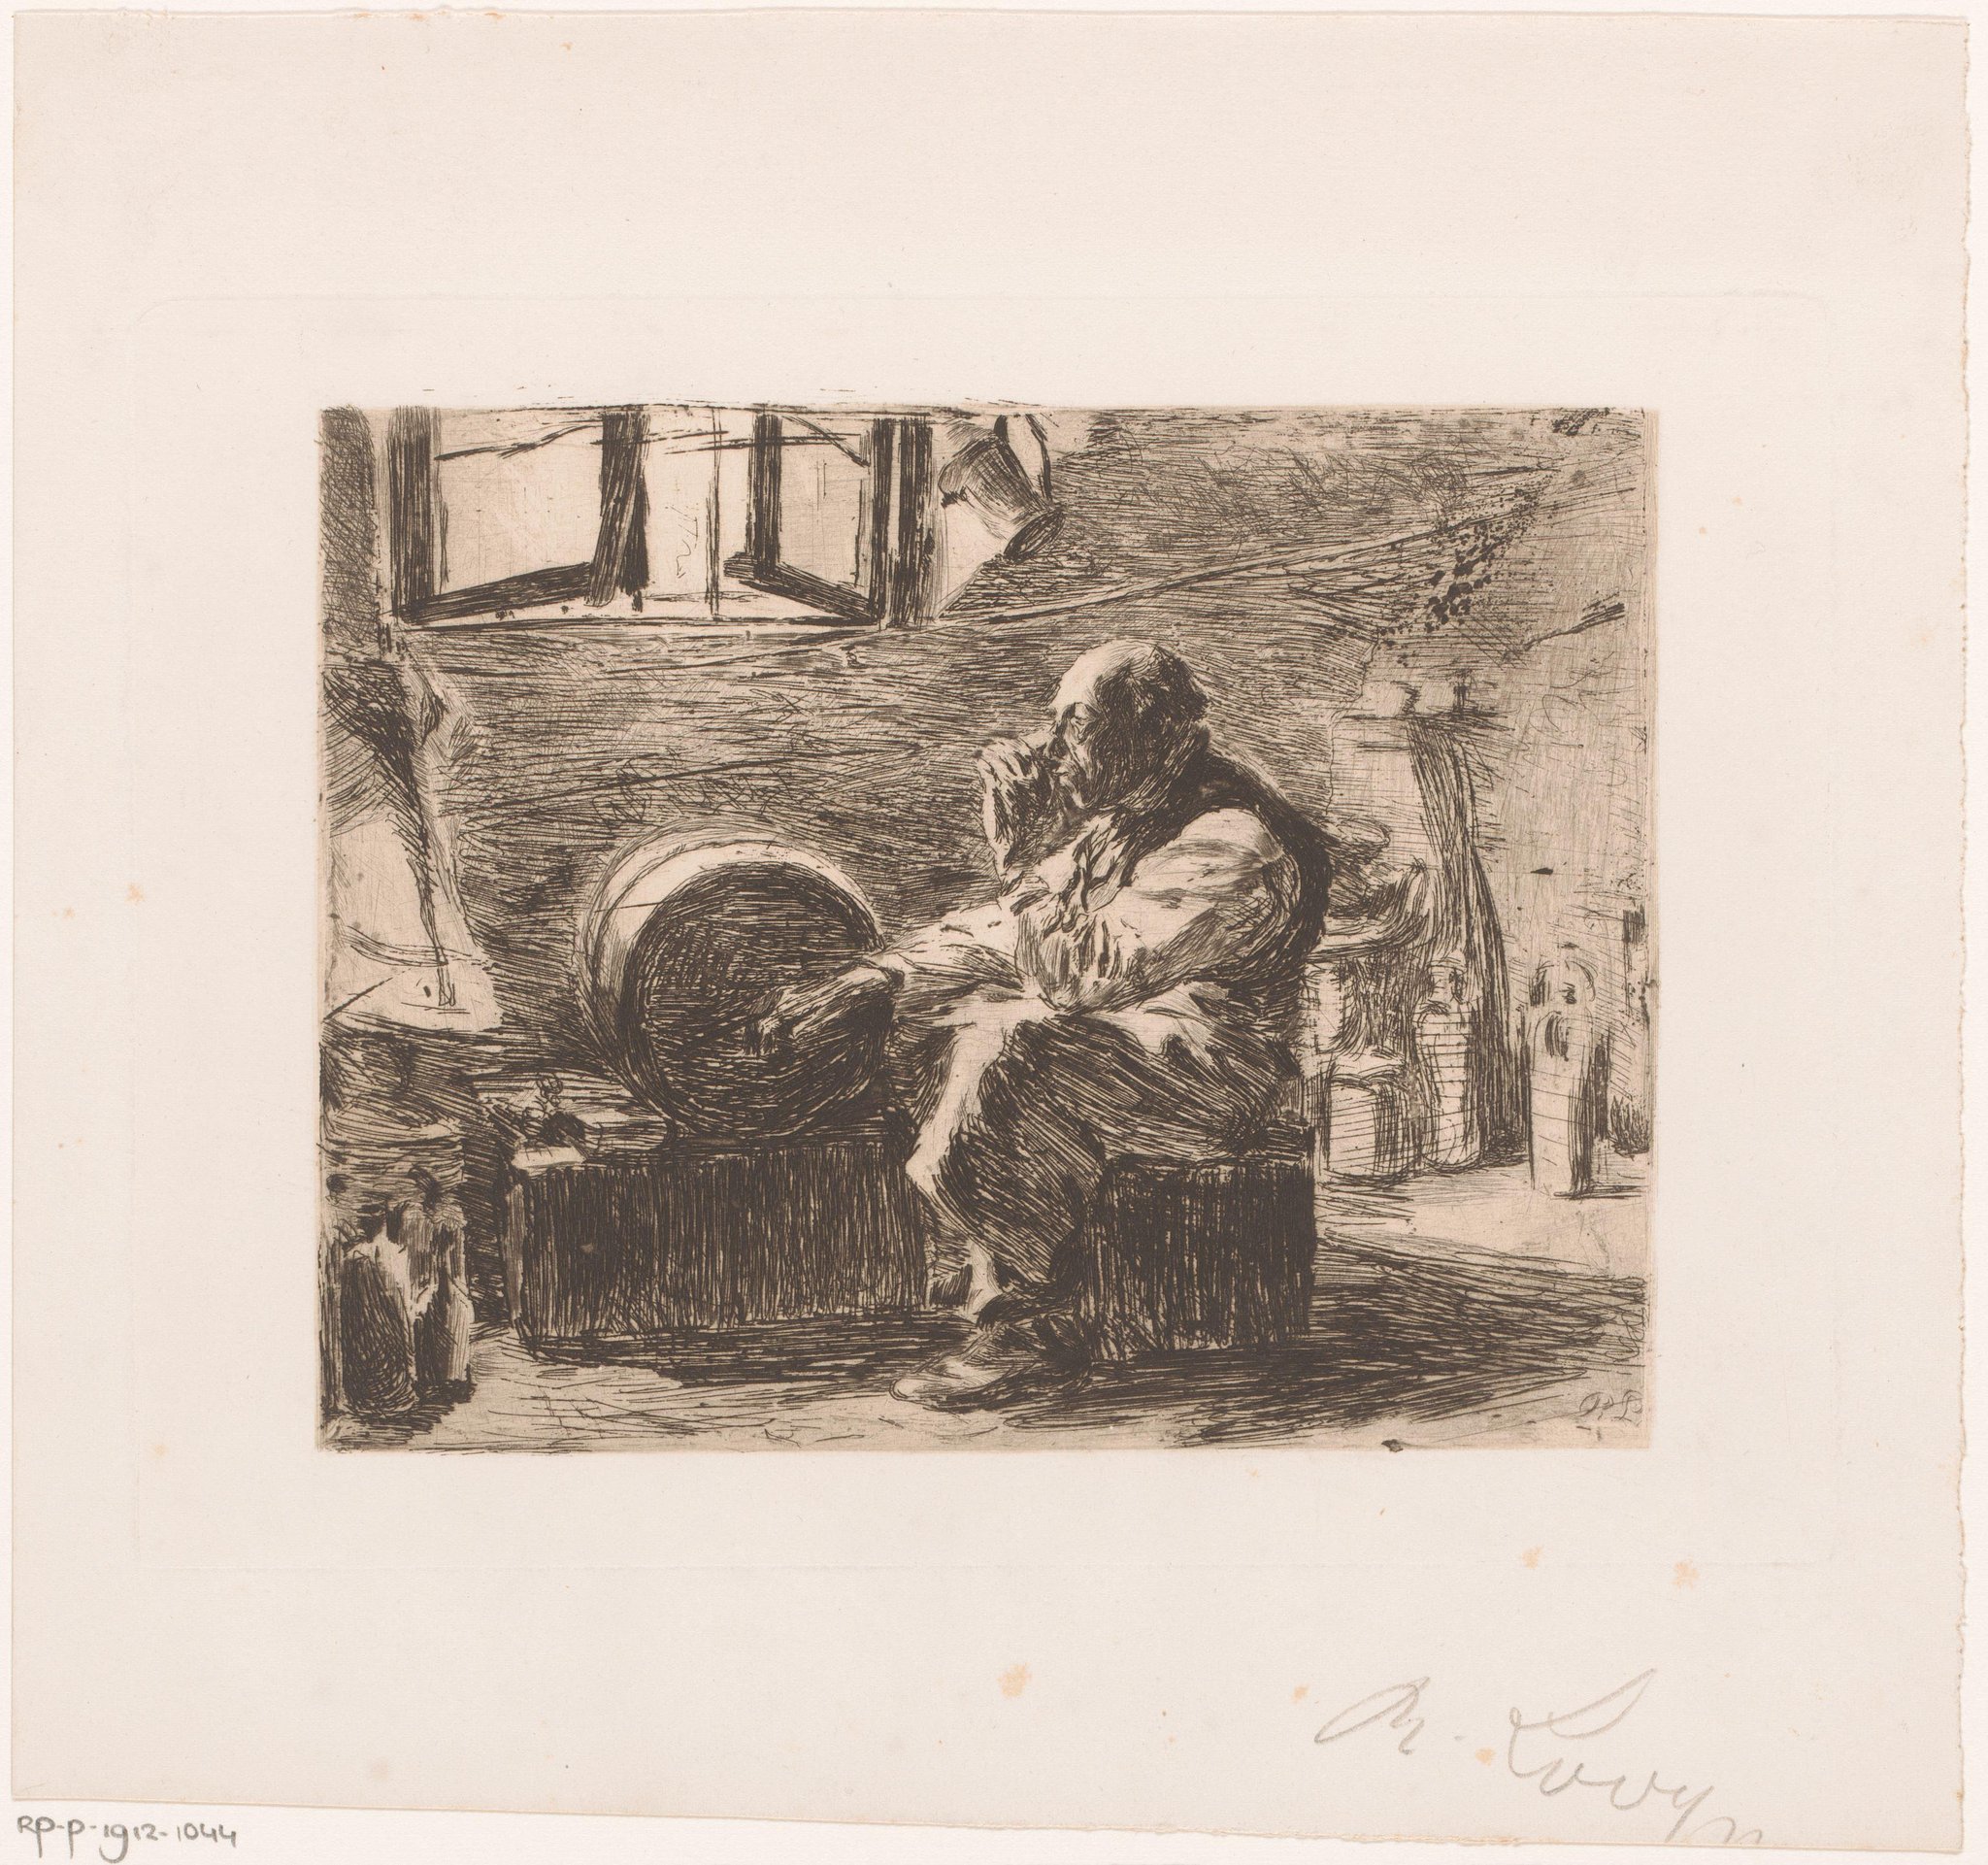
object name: print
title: Kelder met drinkende man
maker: romain looymans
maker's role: print maker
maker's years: 1864-1914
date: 1893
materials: paper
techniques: etching, intaglio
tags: alcoholic drinks, basement, cellar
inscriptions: collector's mark: Lugt 2228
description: Prent uit de suite XIII, 1893. Dit was een periodieke uitgave van de kunstenaarskring Cercle des XIII.